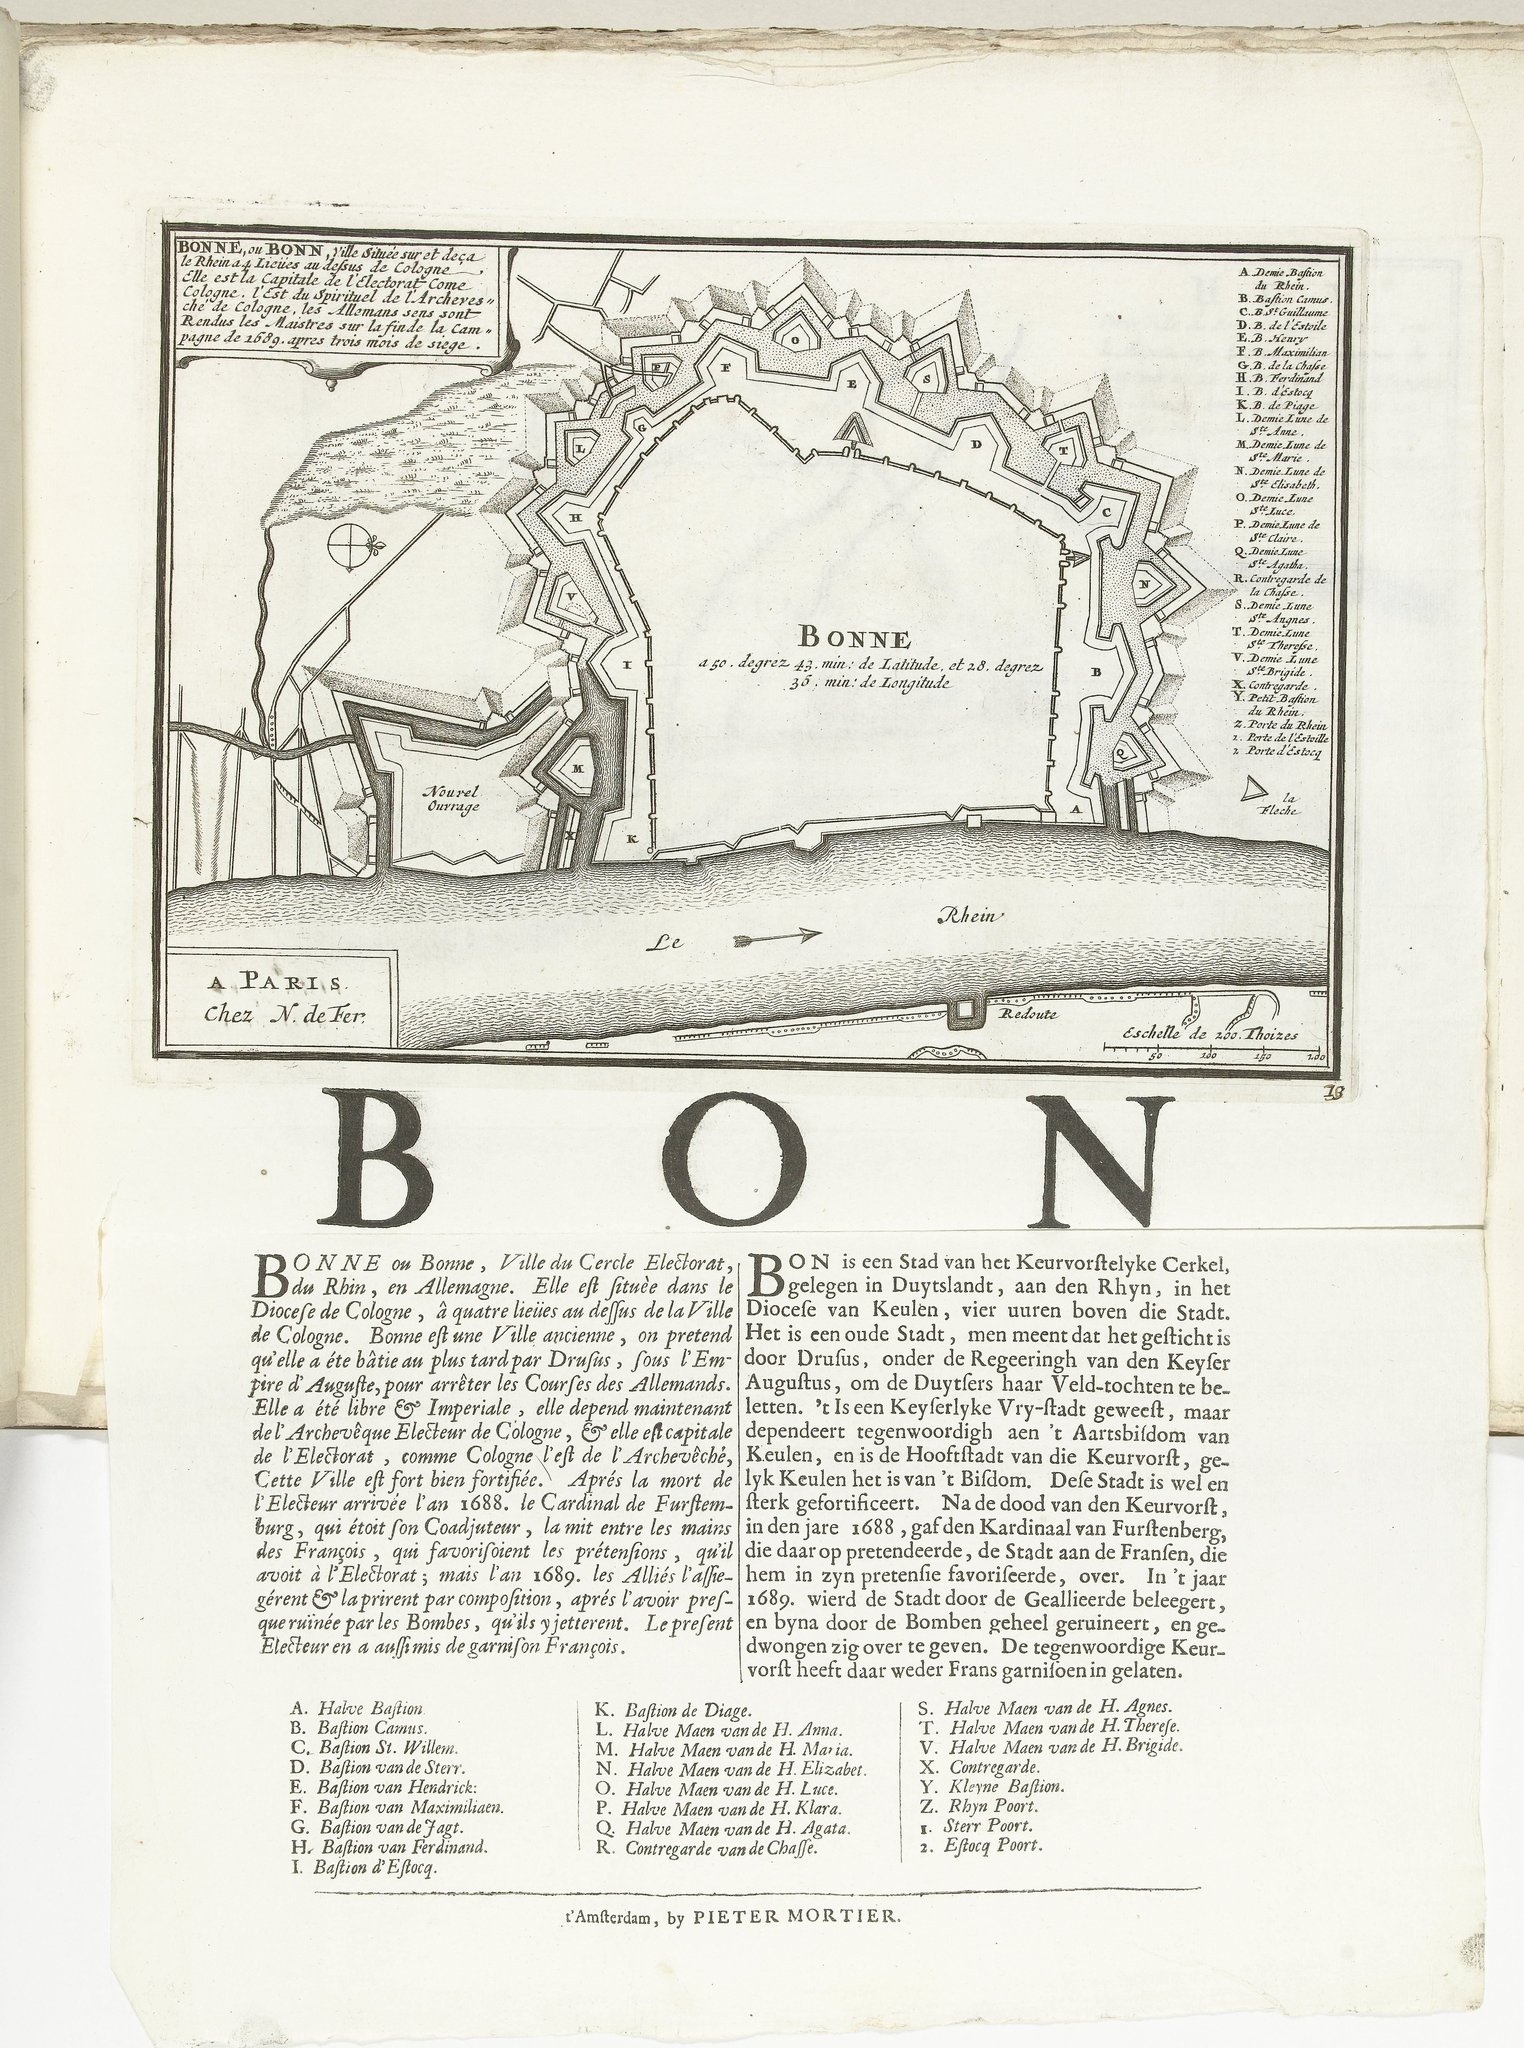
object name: print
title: Les Forces de l'Europe, Asie, Afrique et Amerique, ou description des principales villes avec leurs fortifications. Dessignées par les meilleurs ingenieurs, particulierement celles qui sont sous la domination de la France (...) et ornées de plusieurs superbes edifices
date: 1702-1703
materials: paper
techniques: etching, letterpress printing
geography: paris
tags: fortress, maps of cities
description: Plattegrond van de verdedigingswerken om de stad Bonn. Oud nummer rechtsonder: 13. Plaat nr. 29 in het prentwerk bestaande in totaal uit 276 genummerde platen van vermaarde sterke steden en vestingen in het kader van de Spaanse Successieoorlog. Voor het merendeel zijn deze platen gekopieerd naar de anonieme Franse platen: in Les forces de l'Europe en in: Le theatre de la guerre, dans les Pays-Bas, beide oorspronkelijk uitgegeven door Nicolas de Fer te Parijs (1693-1697) in het kader van de Negenjarige Oorlog. Titel en opschriften in de plaat in het Frans, tekst op het blad onder de plaat in het Frans en Nederlands.